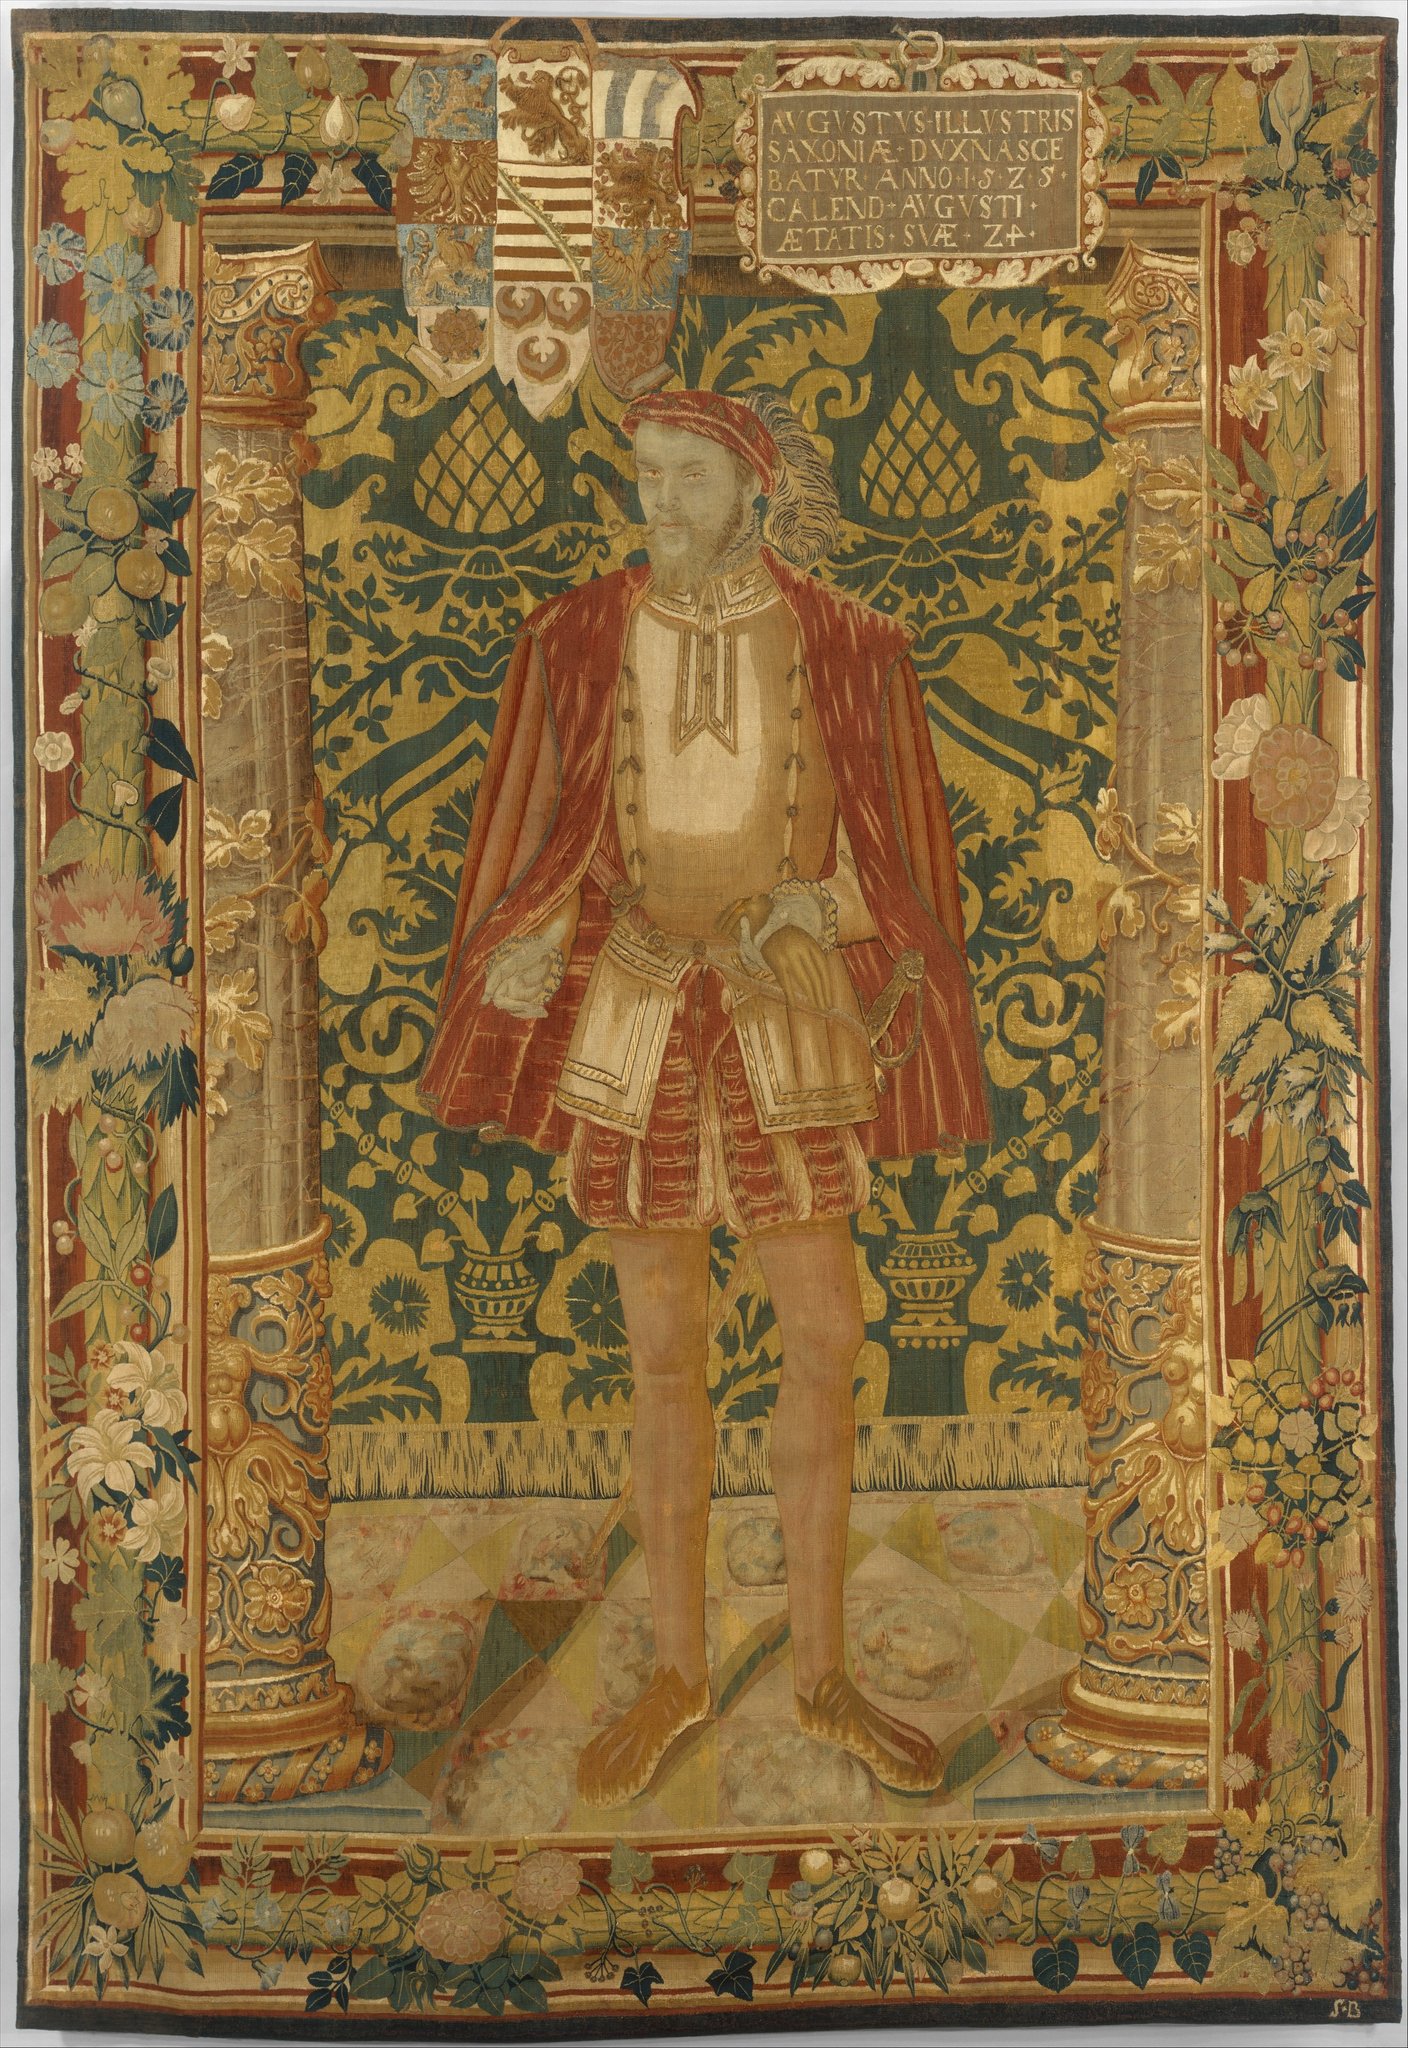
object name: tapestry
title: Augustus I of Saxony (1526–1586)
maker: seger bombeck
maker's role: maker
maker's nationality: german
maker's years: 1545-1552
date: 1550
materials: silk, silver gilt, thread, wool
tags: men,portraits,coat of arms